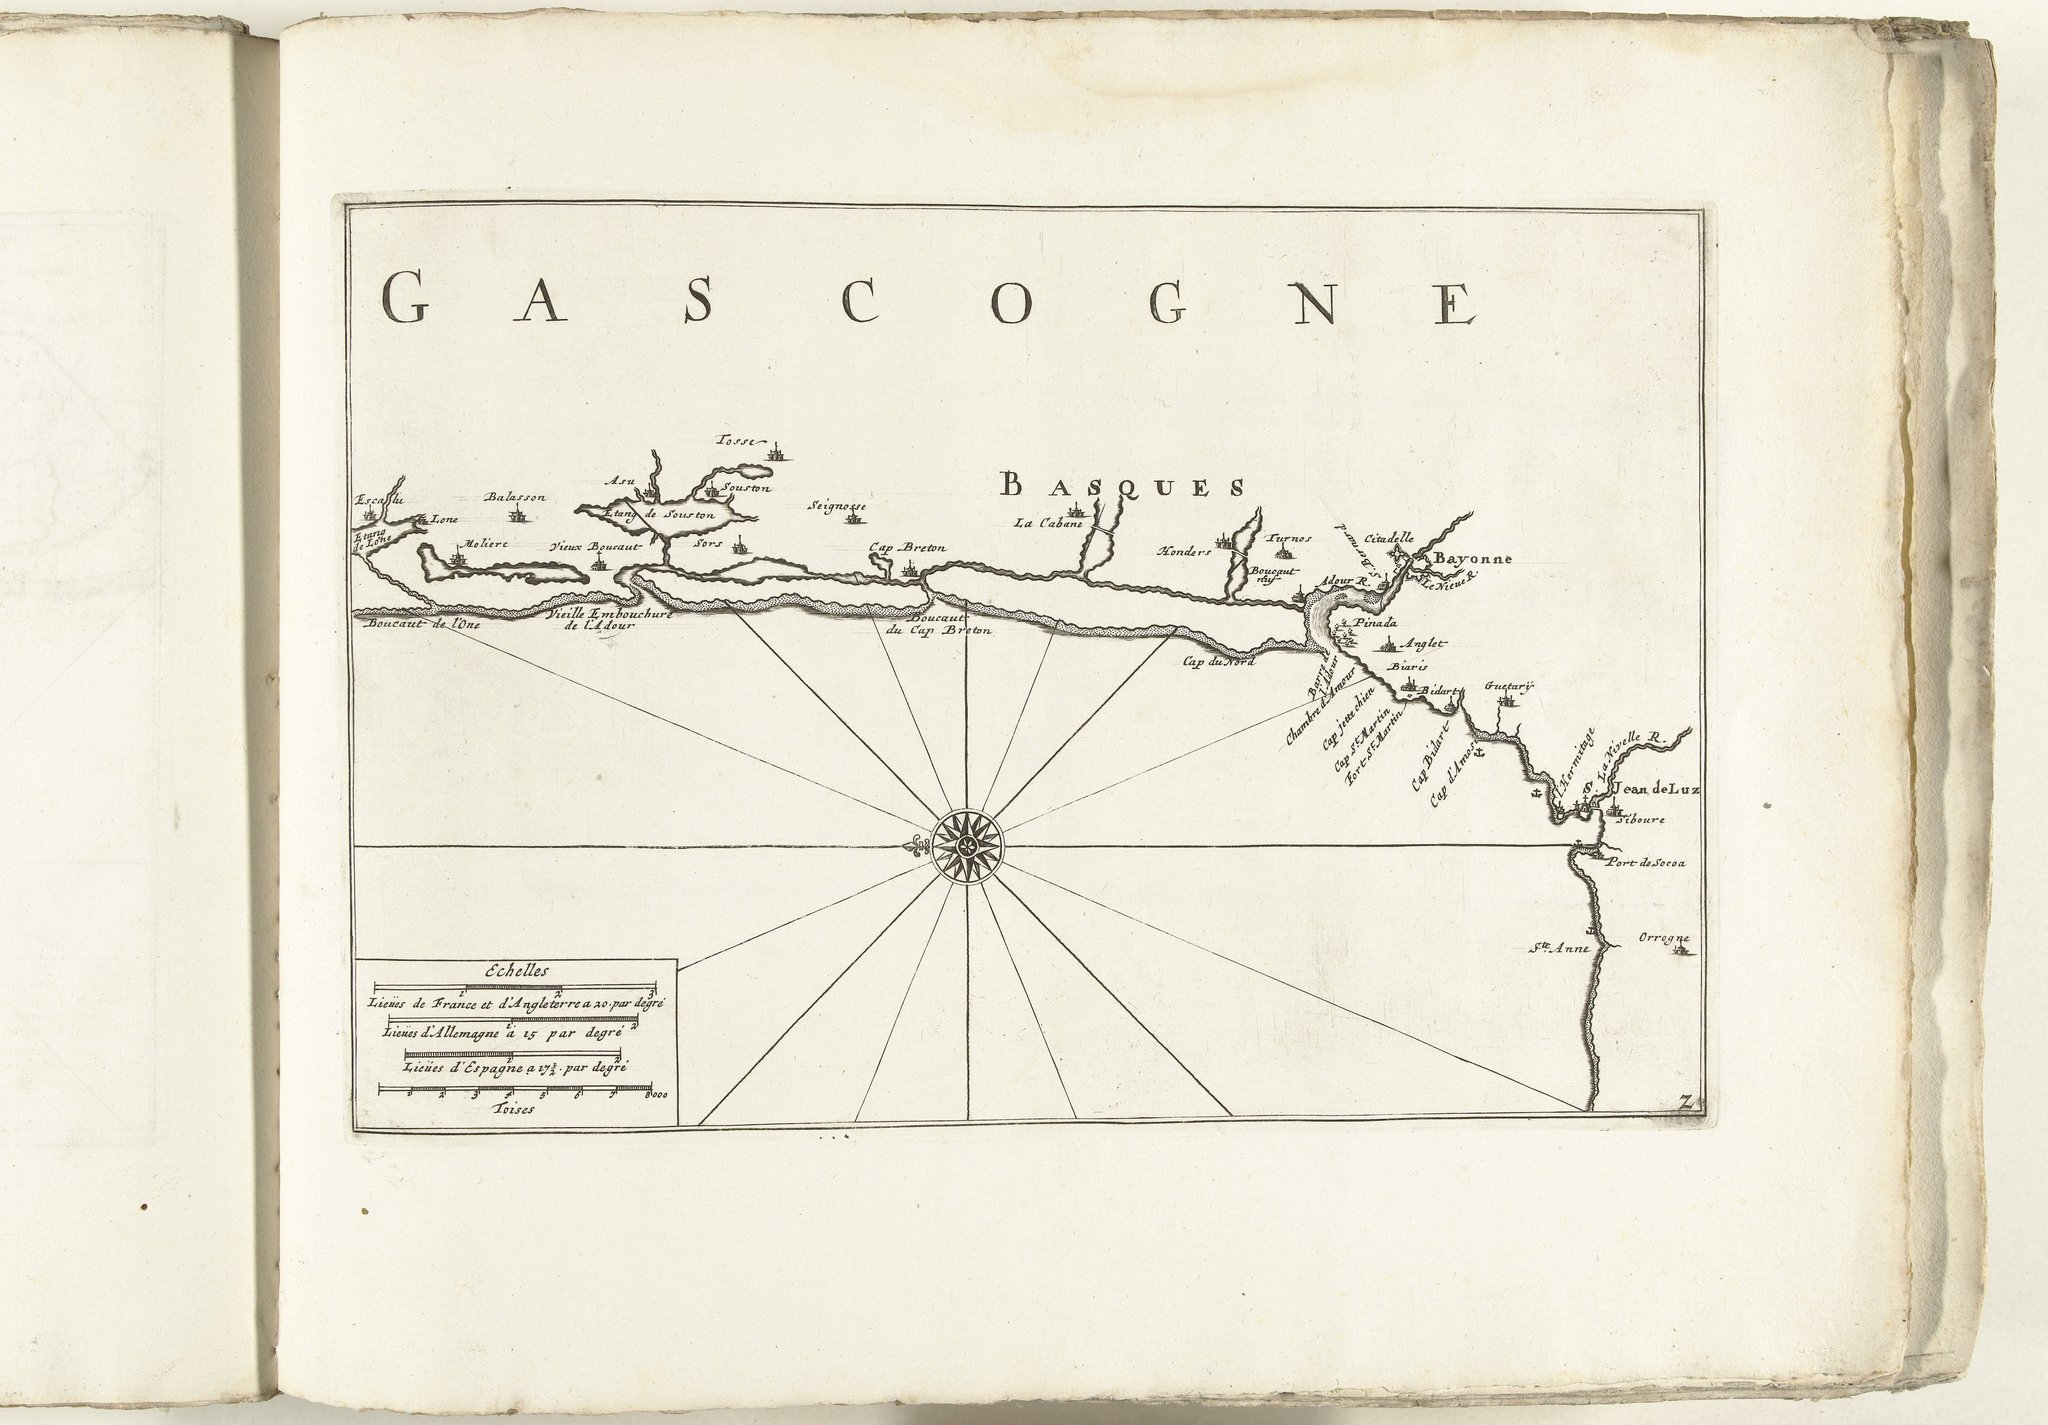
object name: map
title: Les Forces de l'Europe, Asie, Afrique et Amerique, ou description des principales villes avec leurs fortifications. Dessignées par les meilleurs ingenieurs, particulierement celles qui sont sous la domination de la France (...) et ornées de plusieurs superbes edifices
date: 1702-1703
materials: paper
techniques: engraving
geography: northern netherlands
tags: maps of separate countries or regions, france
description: Kaart van de westkust van Gascogne bij Bayonne. Gemerkt rechtsonder: Z. Onderdeel van het tweede van twee delen van het prentwerk: Les costes de France et d'Espagne (oftewel deel 14 van: Les Forces de l'Europe, Asie, Afrique et Amerique), uitgegeven ca. 1702. Het prentwerk bestaat in totaal uit 43 gemerkte platen van de kust van Frankrijk en Spanje, in het kader van de Spaanse Successieoorlog. Deze platen zijn gekopieerd naar anonieme Franse platen oorspronkelijk uitgegeven door Nicolas de Fer te Parijs. Titel en opschriften in de plaat in het Frans.